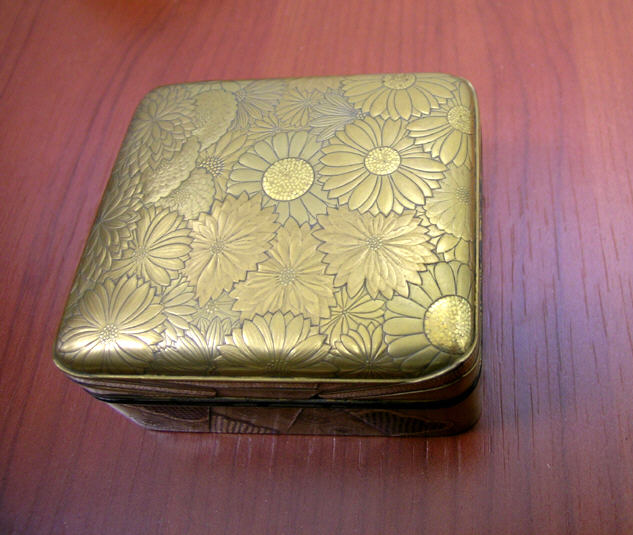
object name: incense box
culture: japanese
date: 1701-1800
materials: gold, lacquer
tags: sunflowers